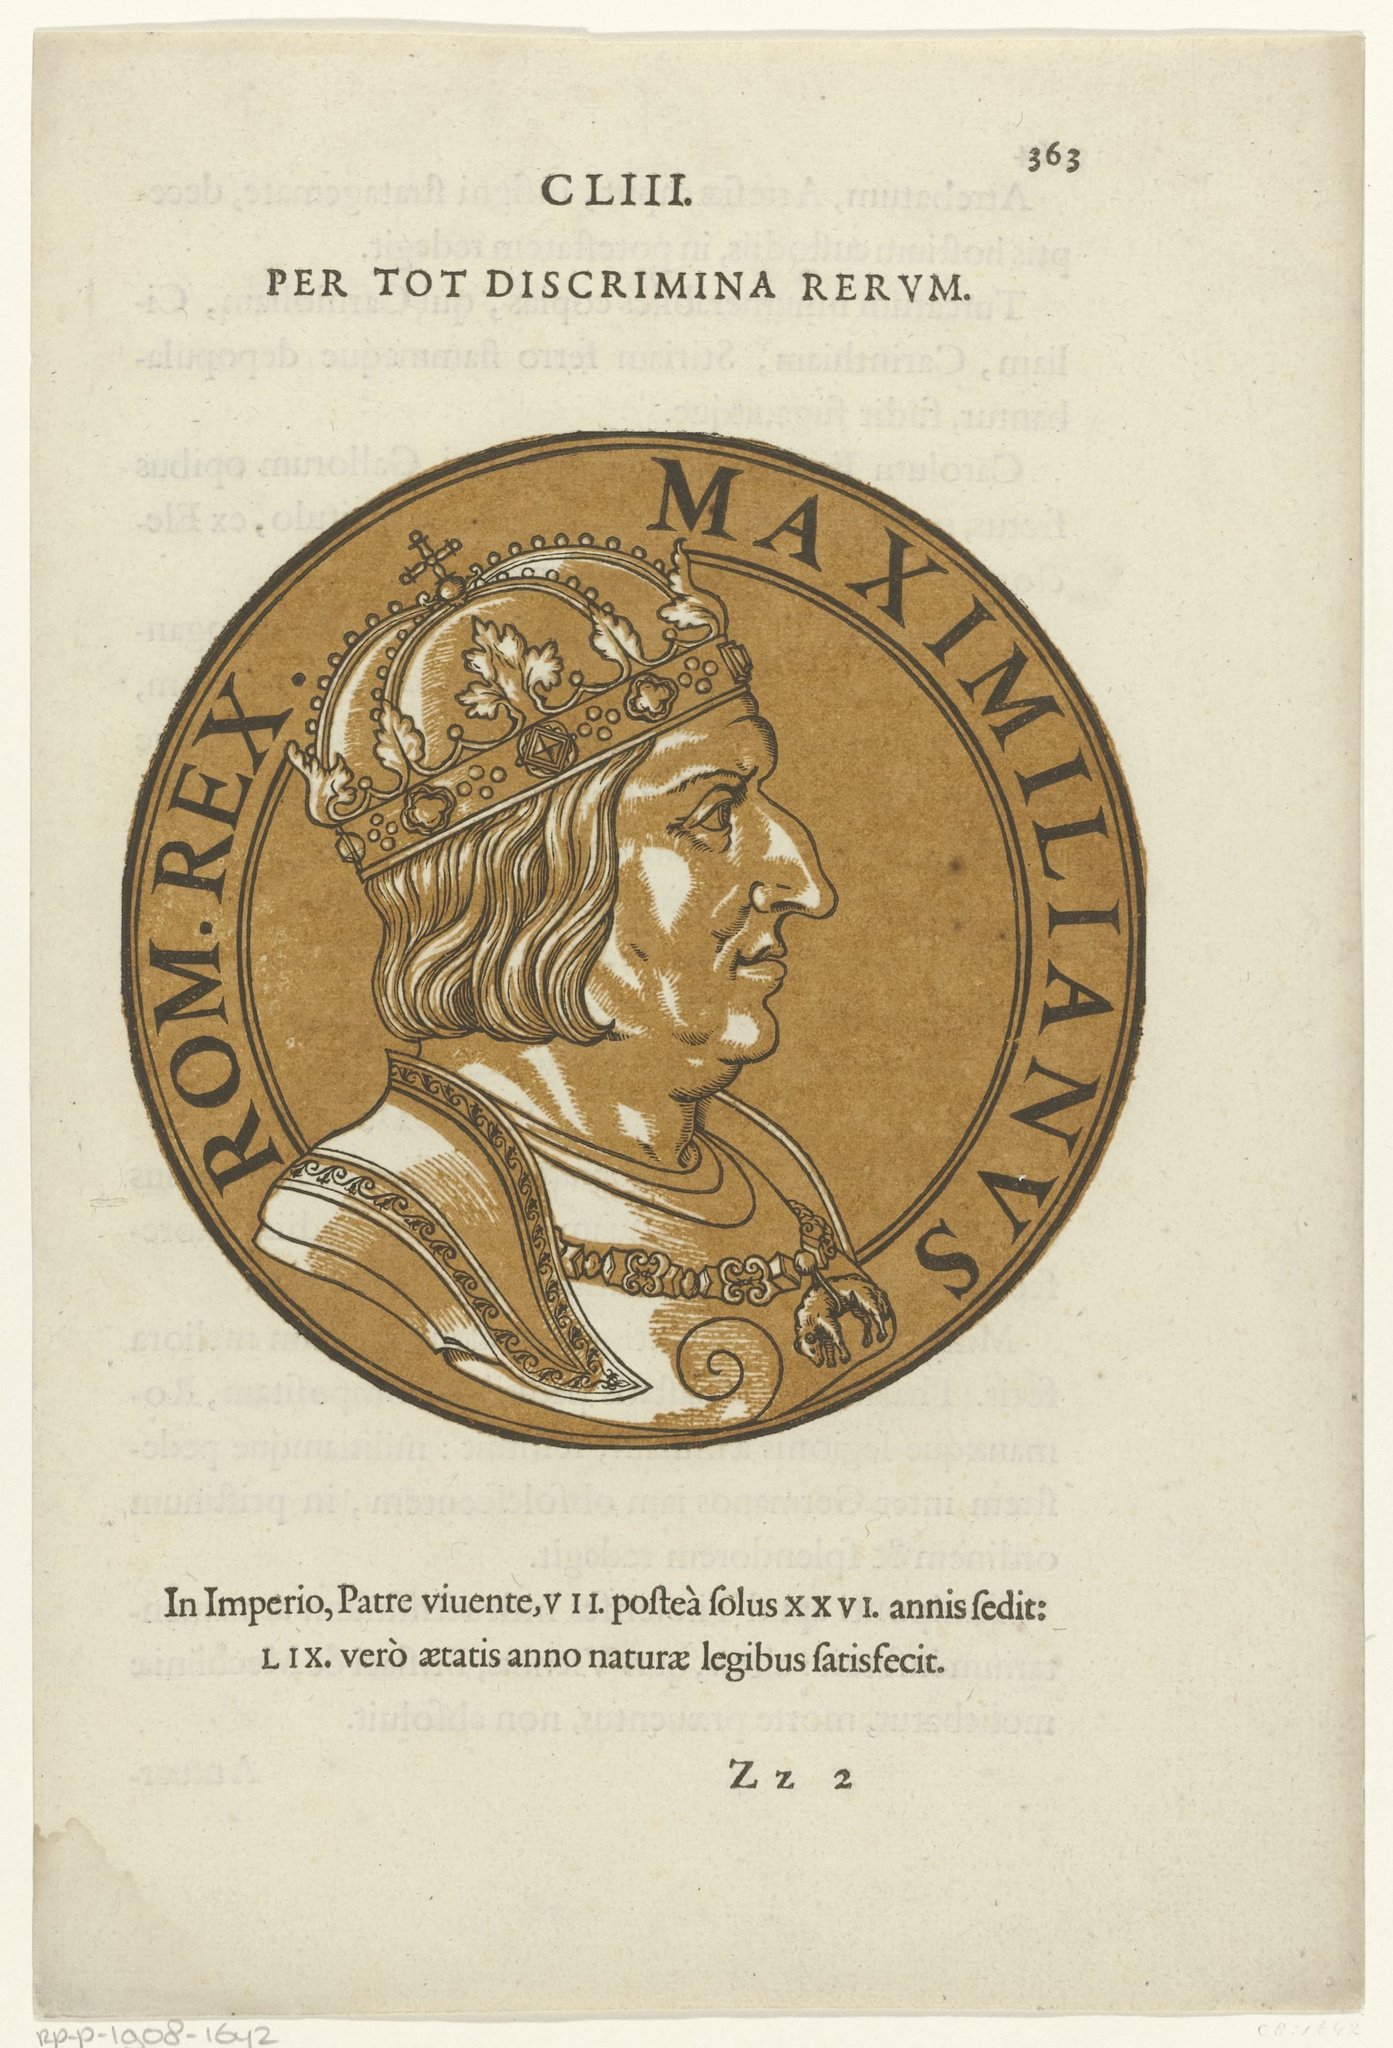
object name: book illustration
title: Icones imperatorum Romanorum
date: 1645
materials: paper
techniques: woodcut, letterpress printing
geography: antwerp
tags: maximilian i (holy roman emperor), knighthood order of the golden fleece, emperor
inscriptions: collector's mark: Lugt 2228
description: Blad afkomstig uit de publicatie: Icones Imperatorum Romanorum, Antwerpen: Ex officina Plantiniana Balthasaris Moreti, 1645, p. 363.